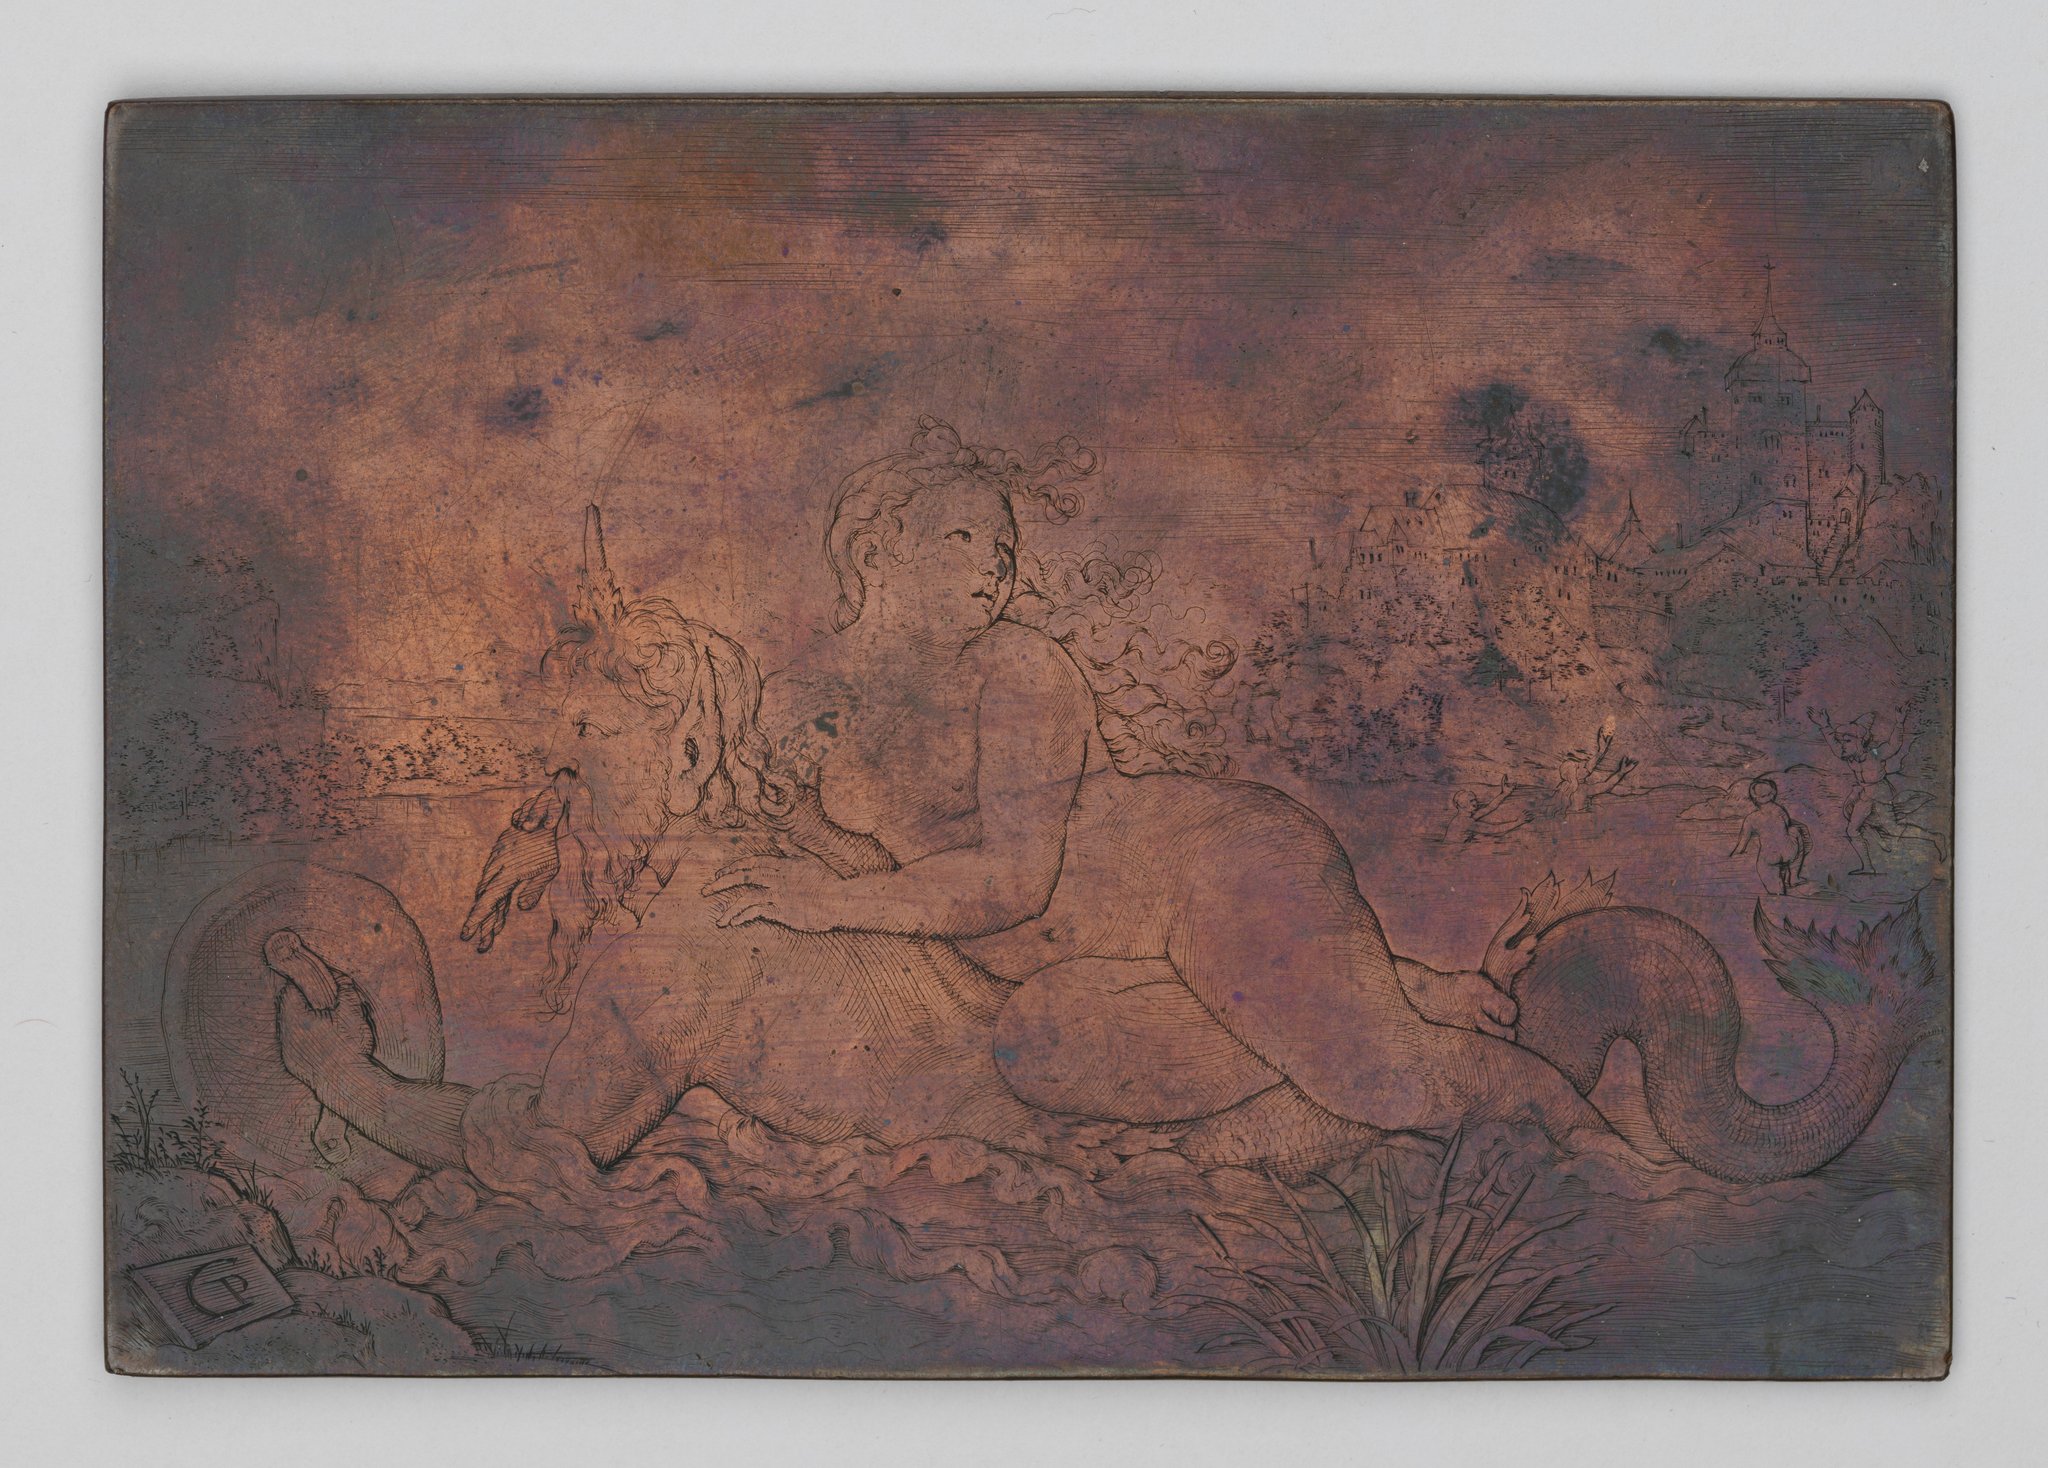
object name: plate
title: Amymone Carried Away by a Sea God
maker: georg pencz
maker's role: artist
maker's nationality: german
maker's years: 1500-1550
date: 1501-1600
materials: copper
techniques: engraving